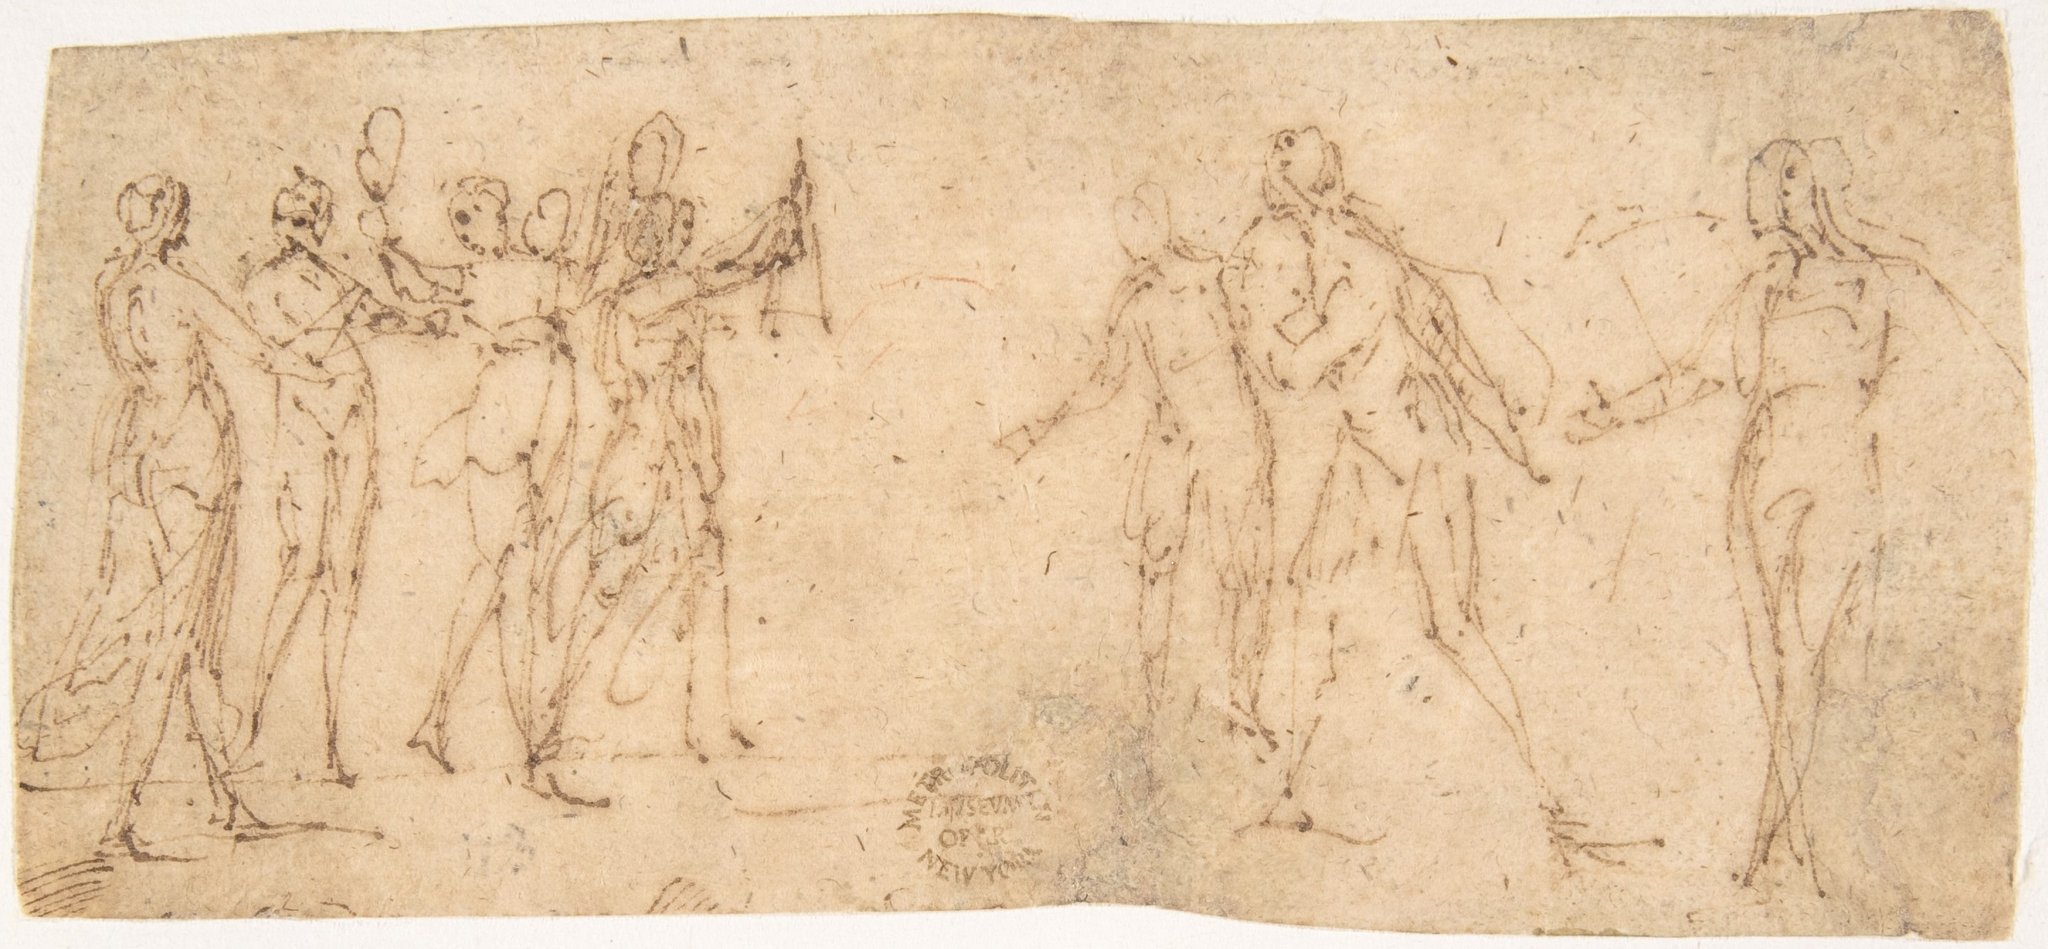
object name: drawing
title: Procession of Musicians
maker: francesco allegrini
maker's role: artist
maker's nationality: italian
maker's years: 1615-1679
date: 1624-1663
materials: ink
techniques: pen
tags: musicians